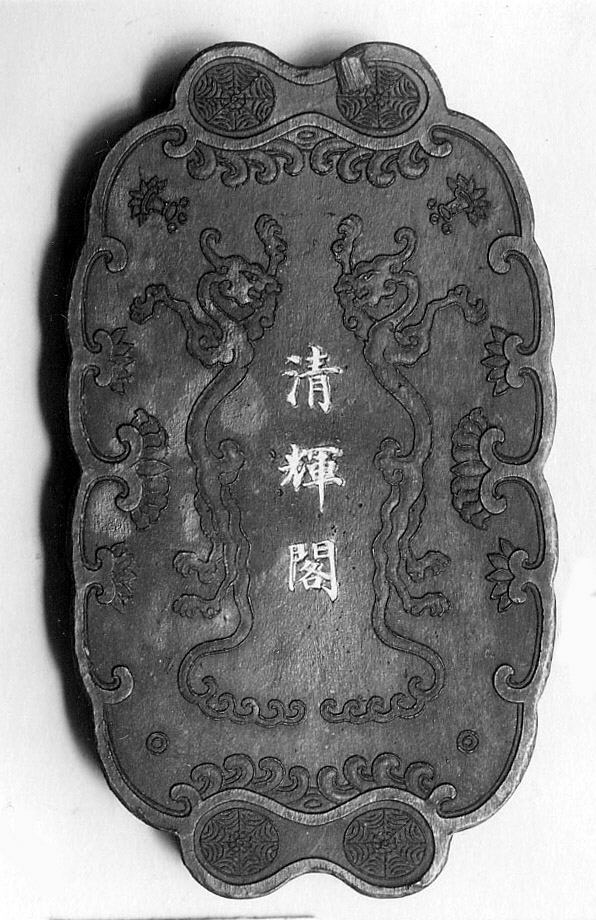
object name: ink tablet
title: Clear Brilliance Terrace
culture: chinese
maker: jian guzhai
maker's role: artist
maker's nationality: chinese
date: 1867-1933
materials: ink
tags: dragons